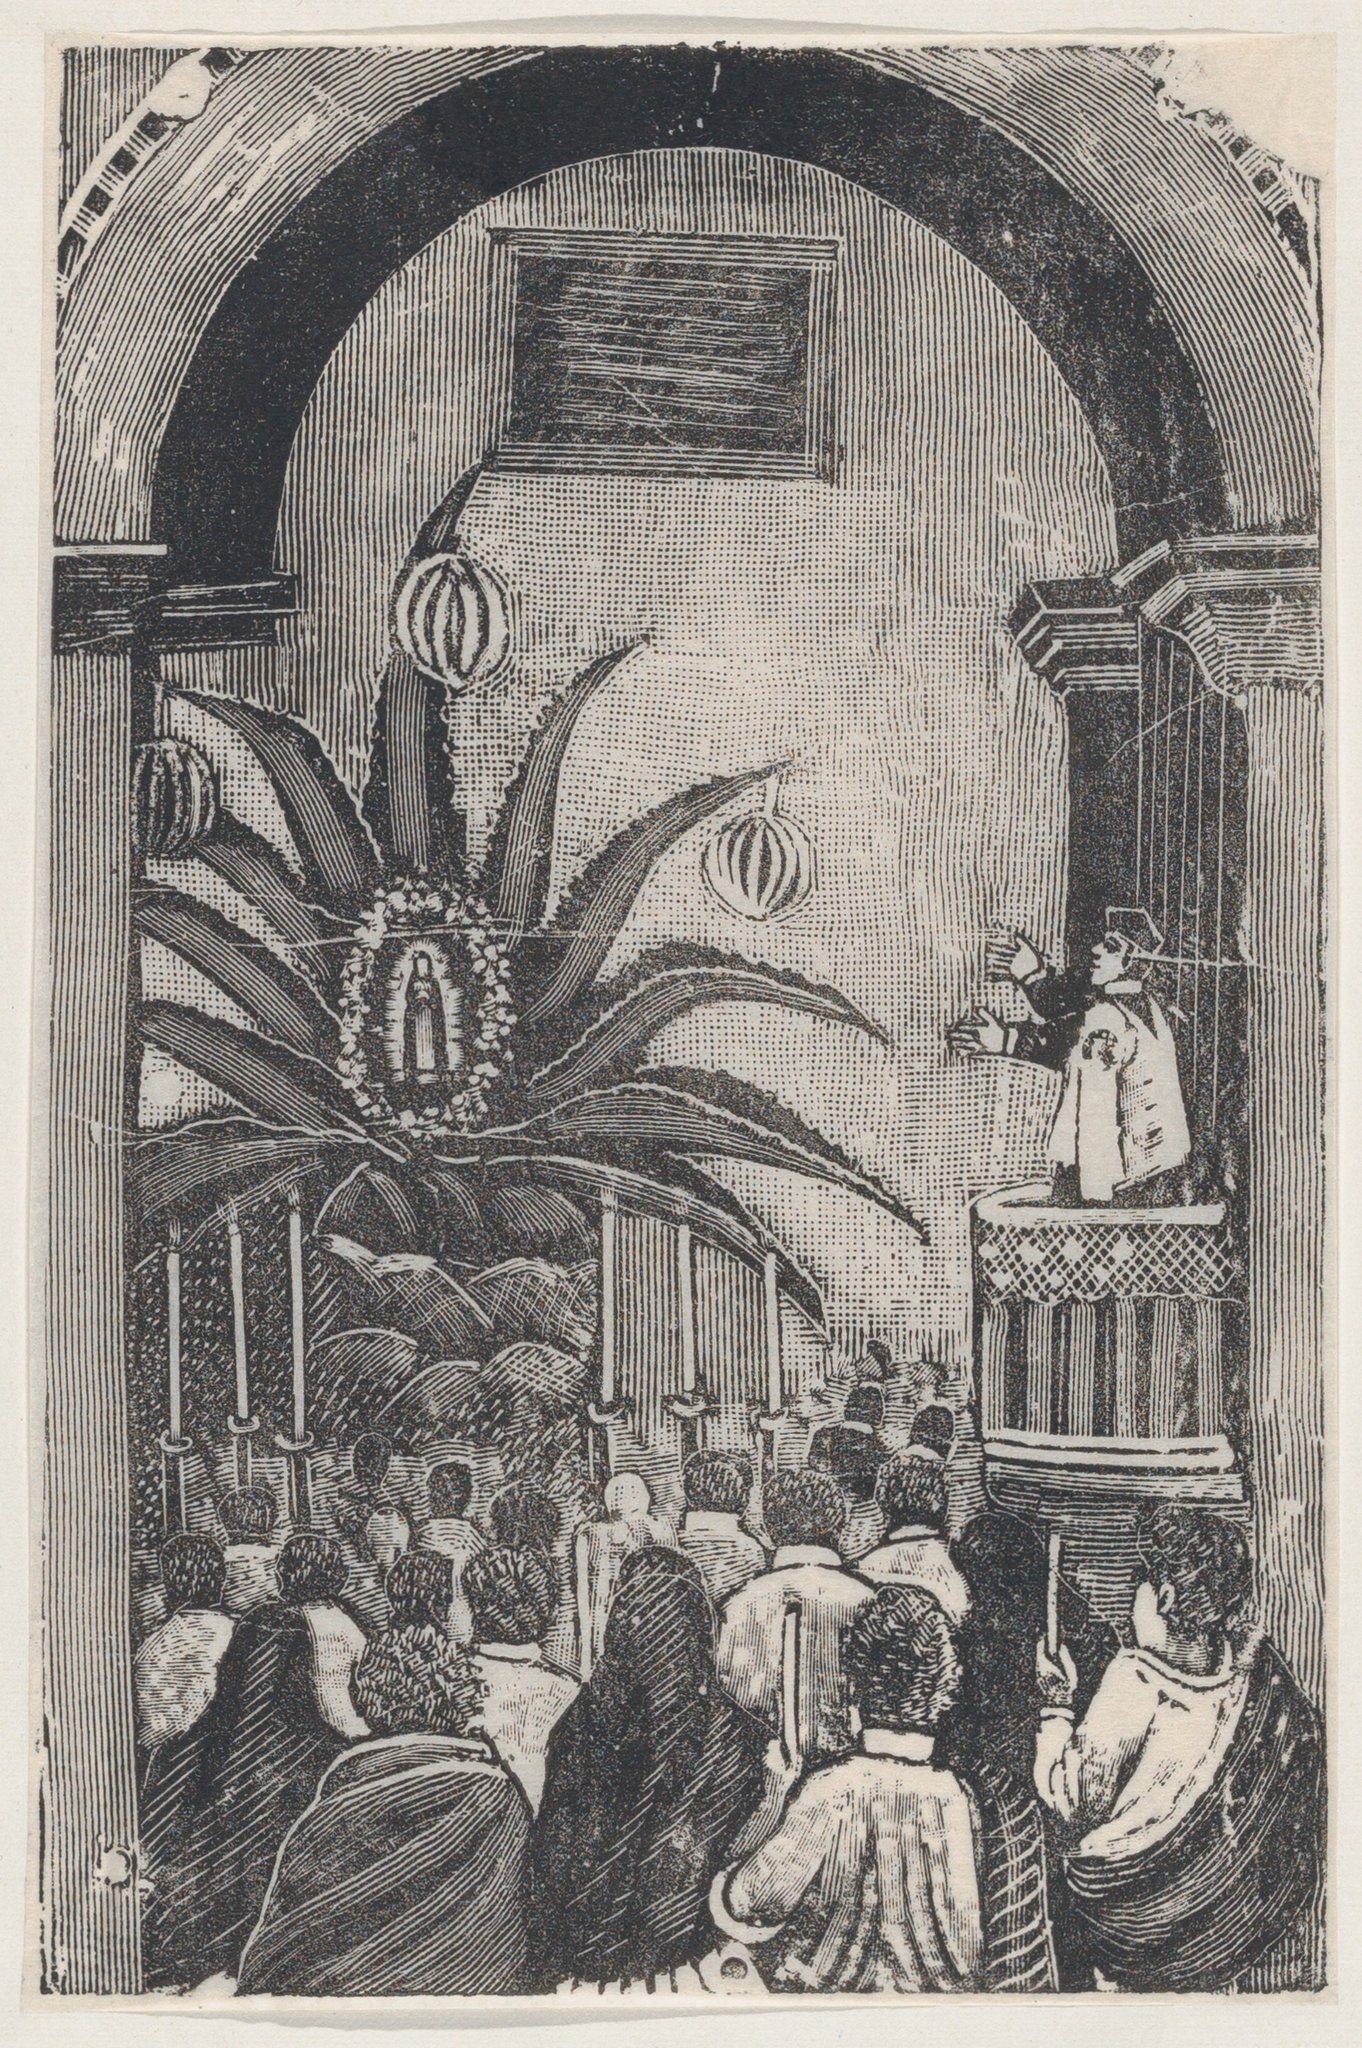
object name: print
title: A priest conducting mass from a balcony, an image of the Virgin of Guadalupe set in palm tree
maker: josé guadalupe posada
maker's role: artist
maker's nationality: mexican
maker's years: 1852-1913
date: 1894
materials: metal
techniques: engraving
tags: men,women,palms,priests